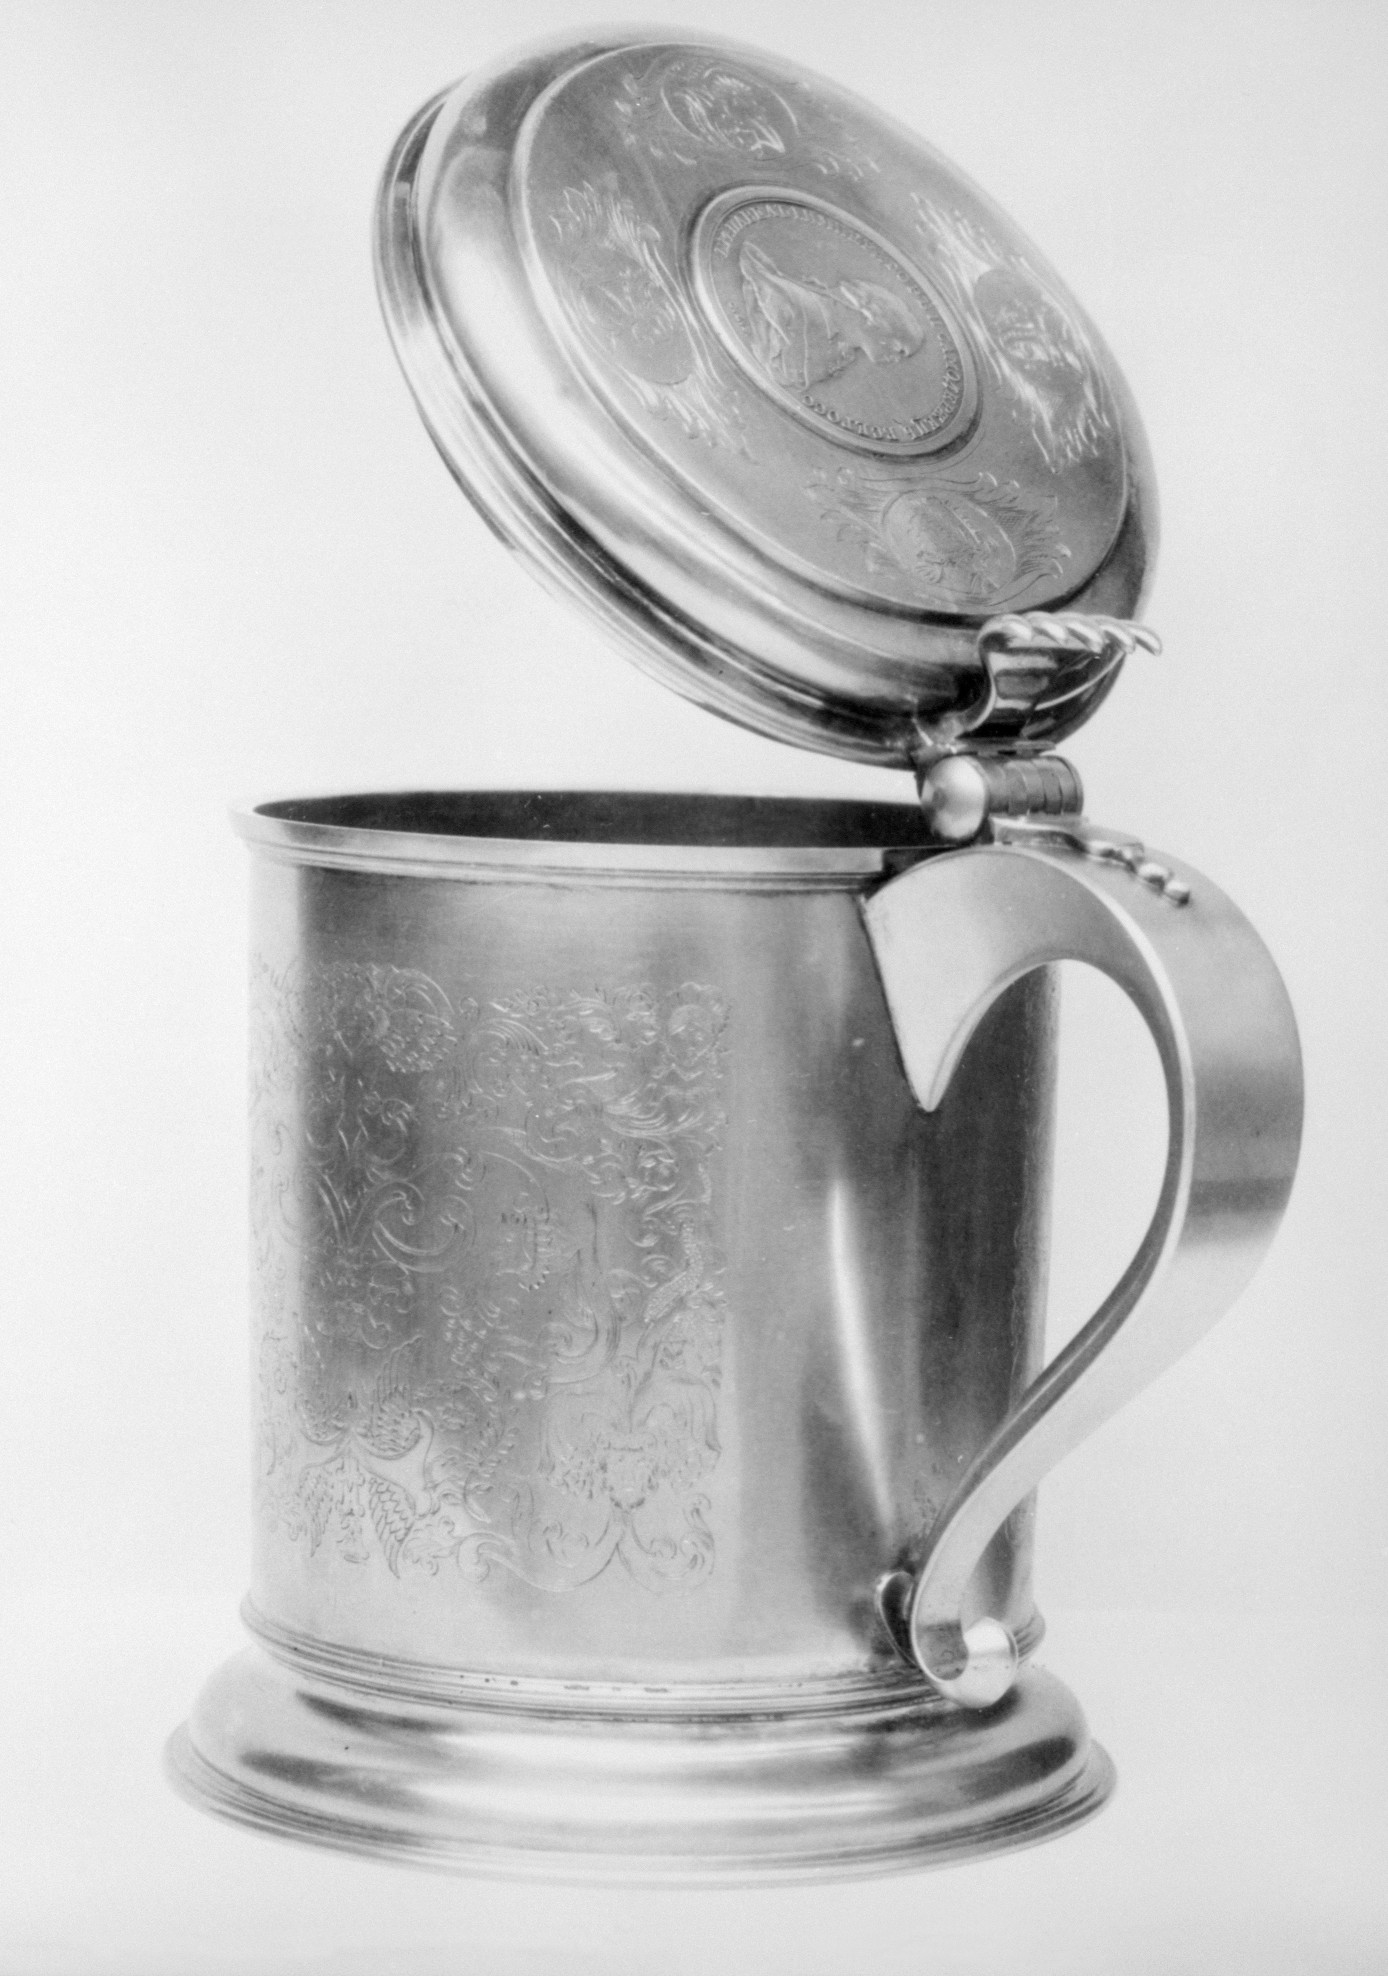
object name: tankard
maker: johan henrik åkerblom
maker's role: maker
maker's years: 1760-1829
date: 1798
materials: silver gilt